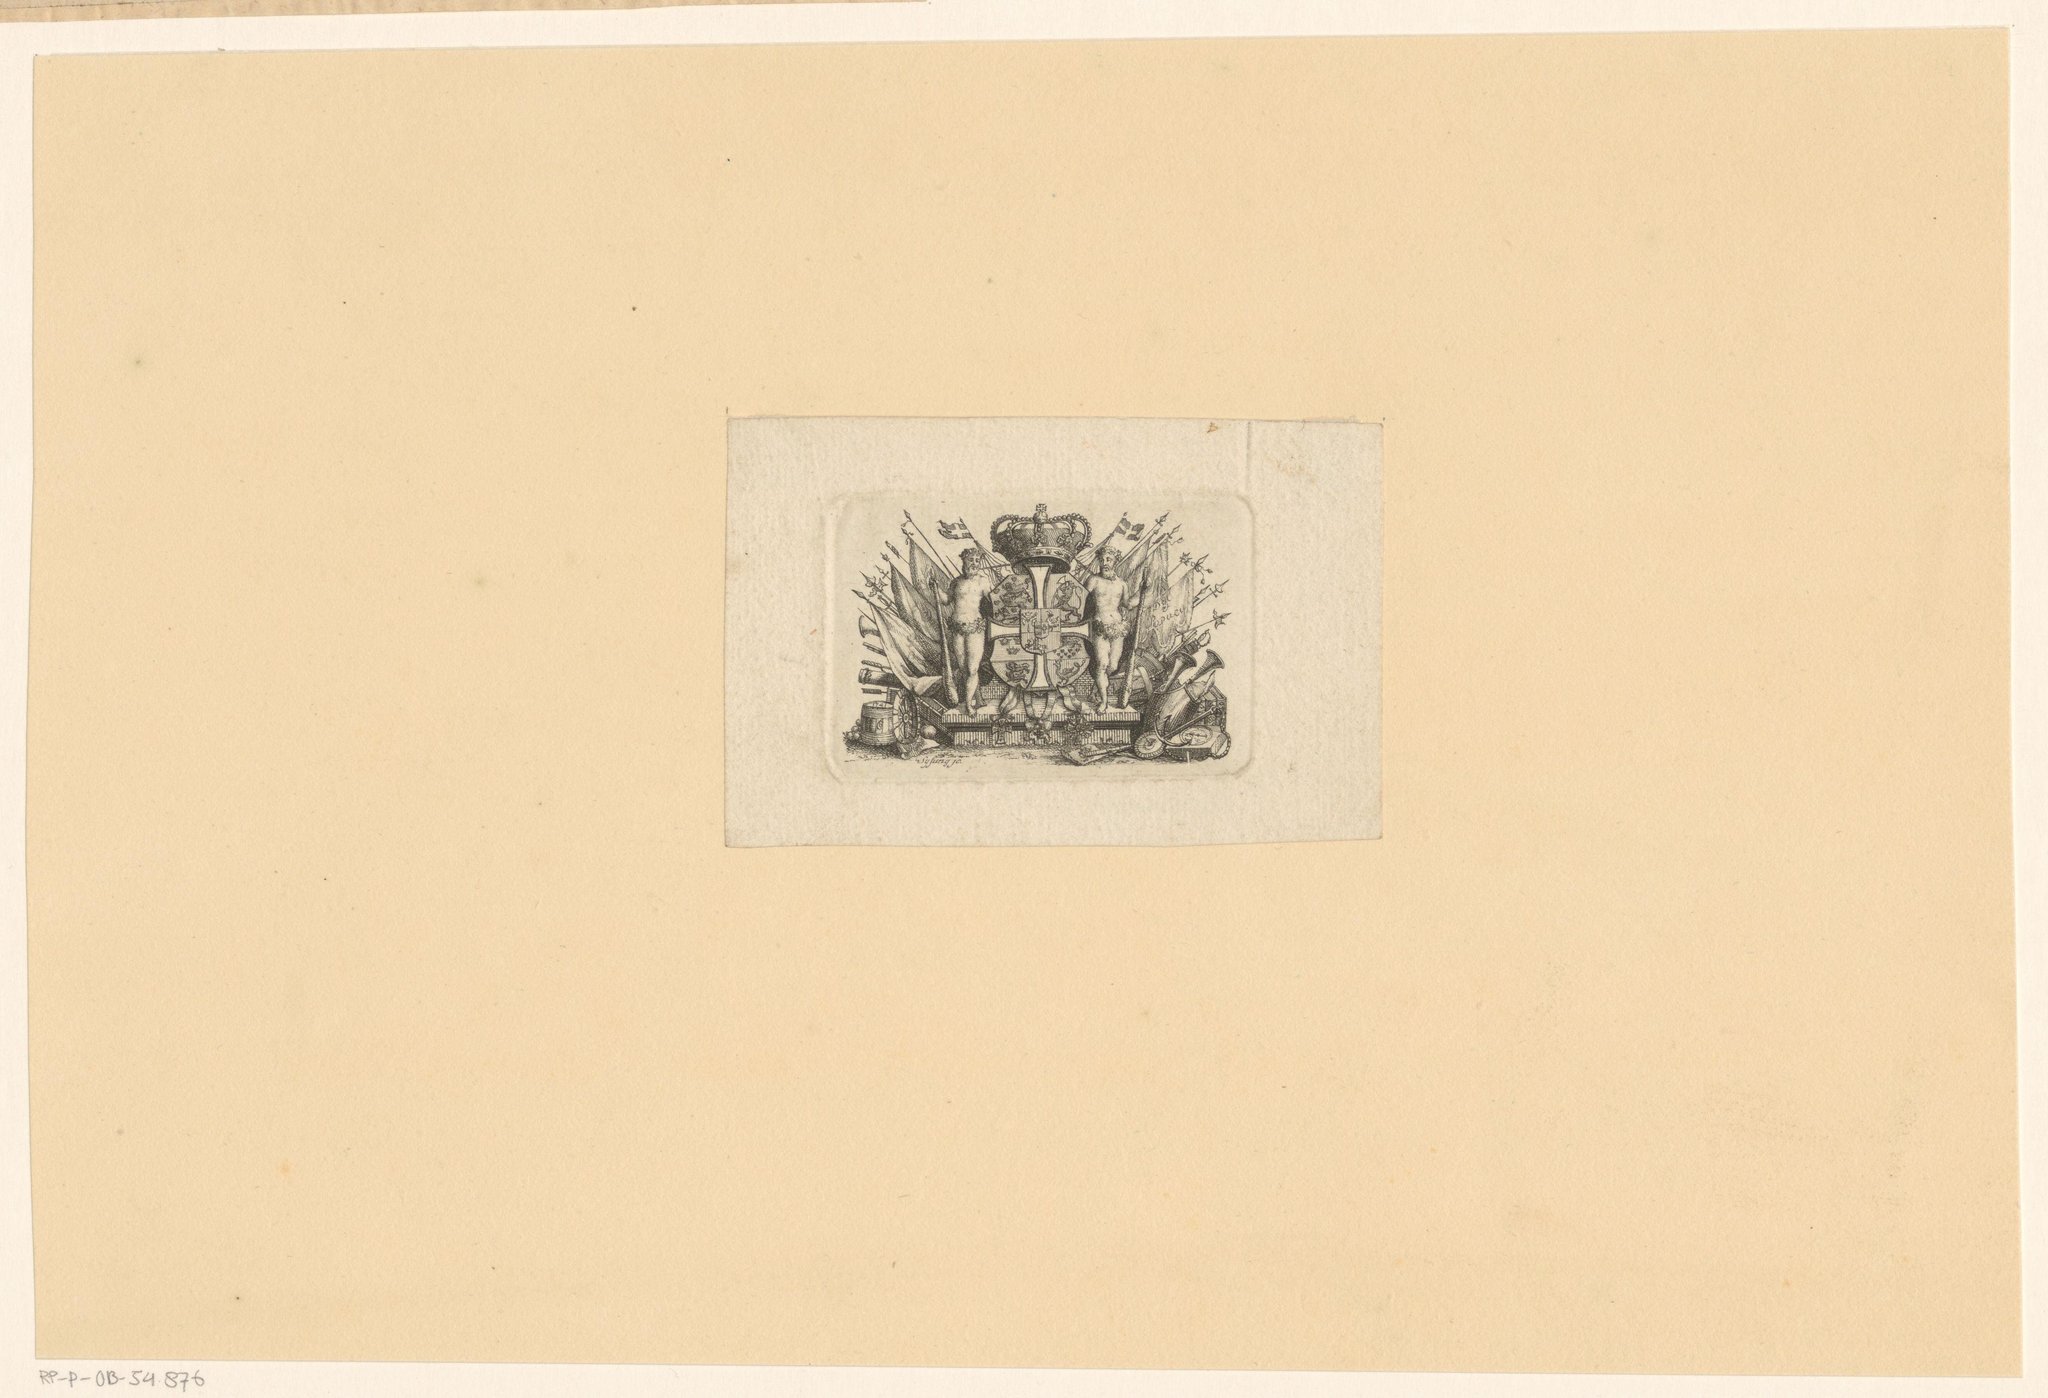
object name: print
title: Wapenschild met kroon geflankeerd door twee mannen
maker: johann christoph sysang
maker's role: print maker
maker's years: 1703-1757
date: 1713-1757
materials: paper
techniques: etching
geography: germany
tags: crown (symbol of sovereignty), historical persons, armorial bearing, heraldry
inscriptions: collector's mark: Lugt 2228